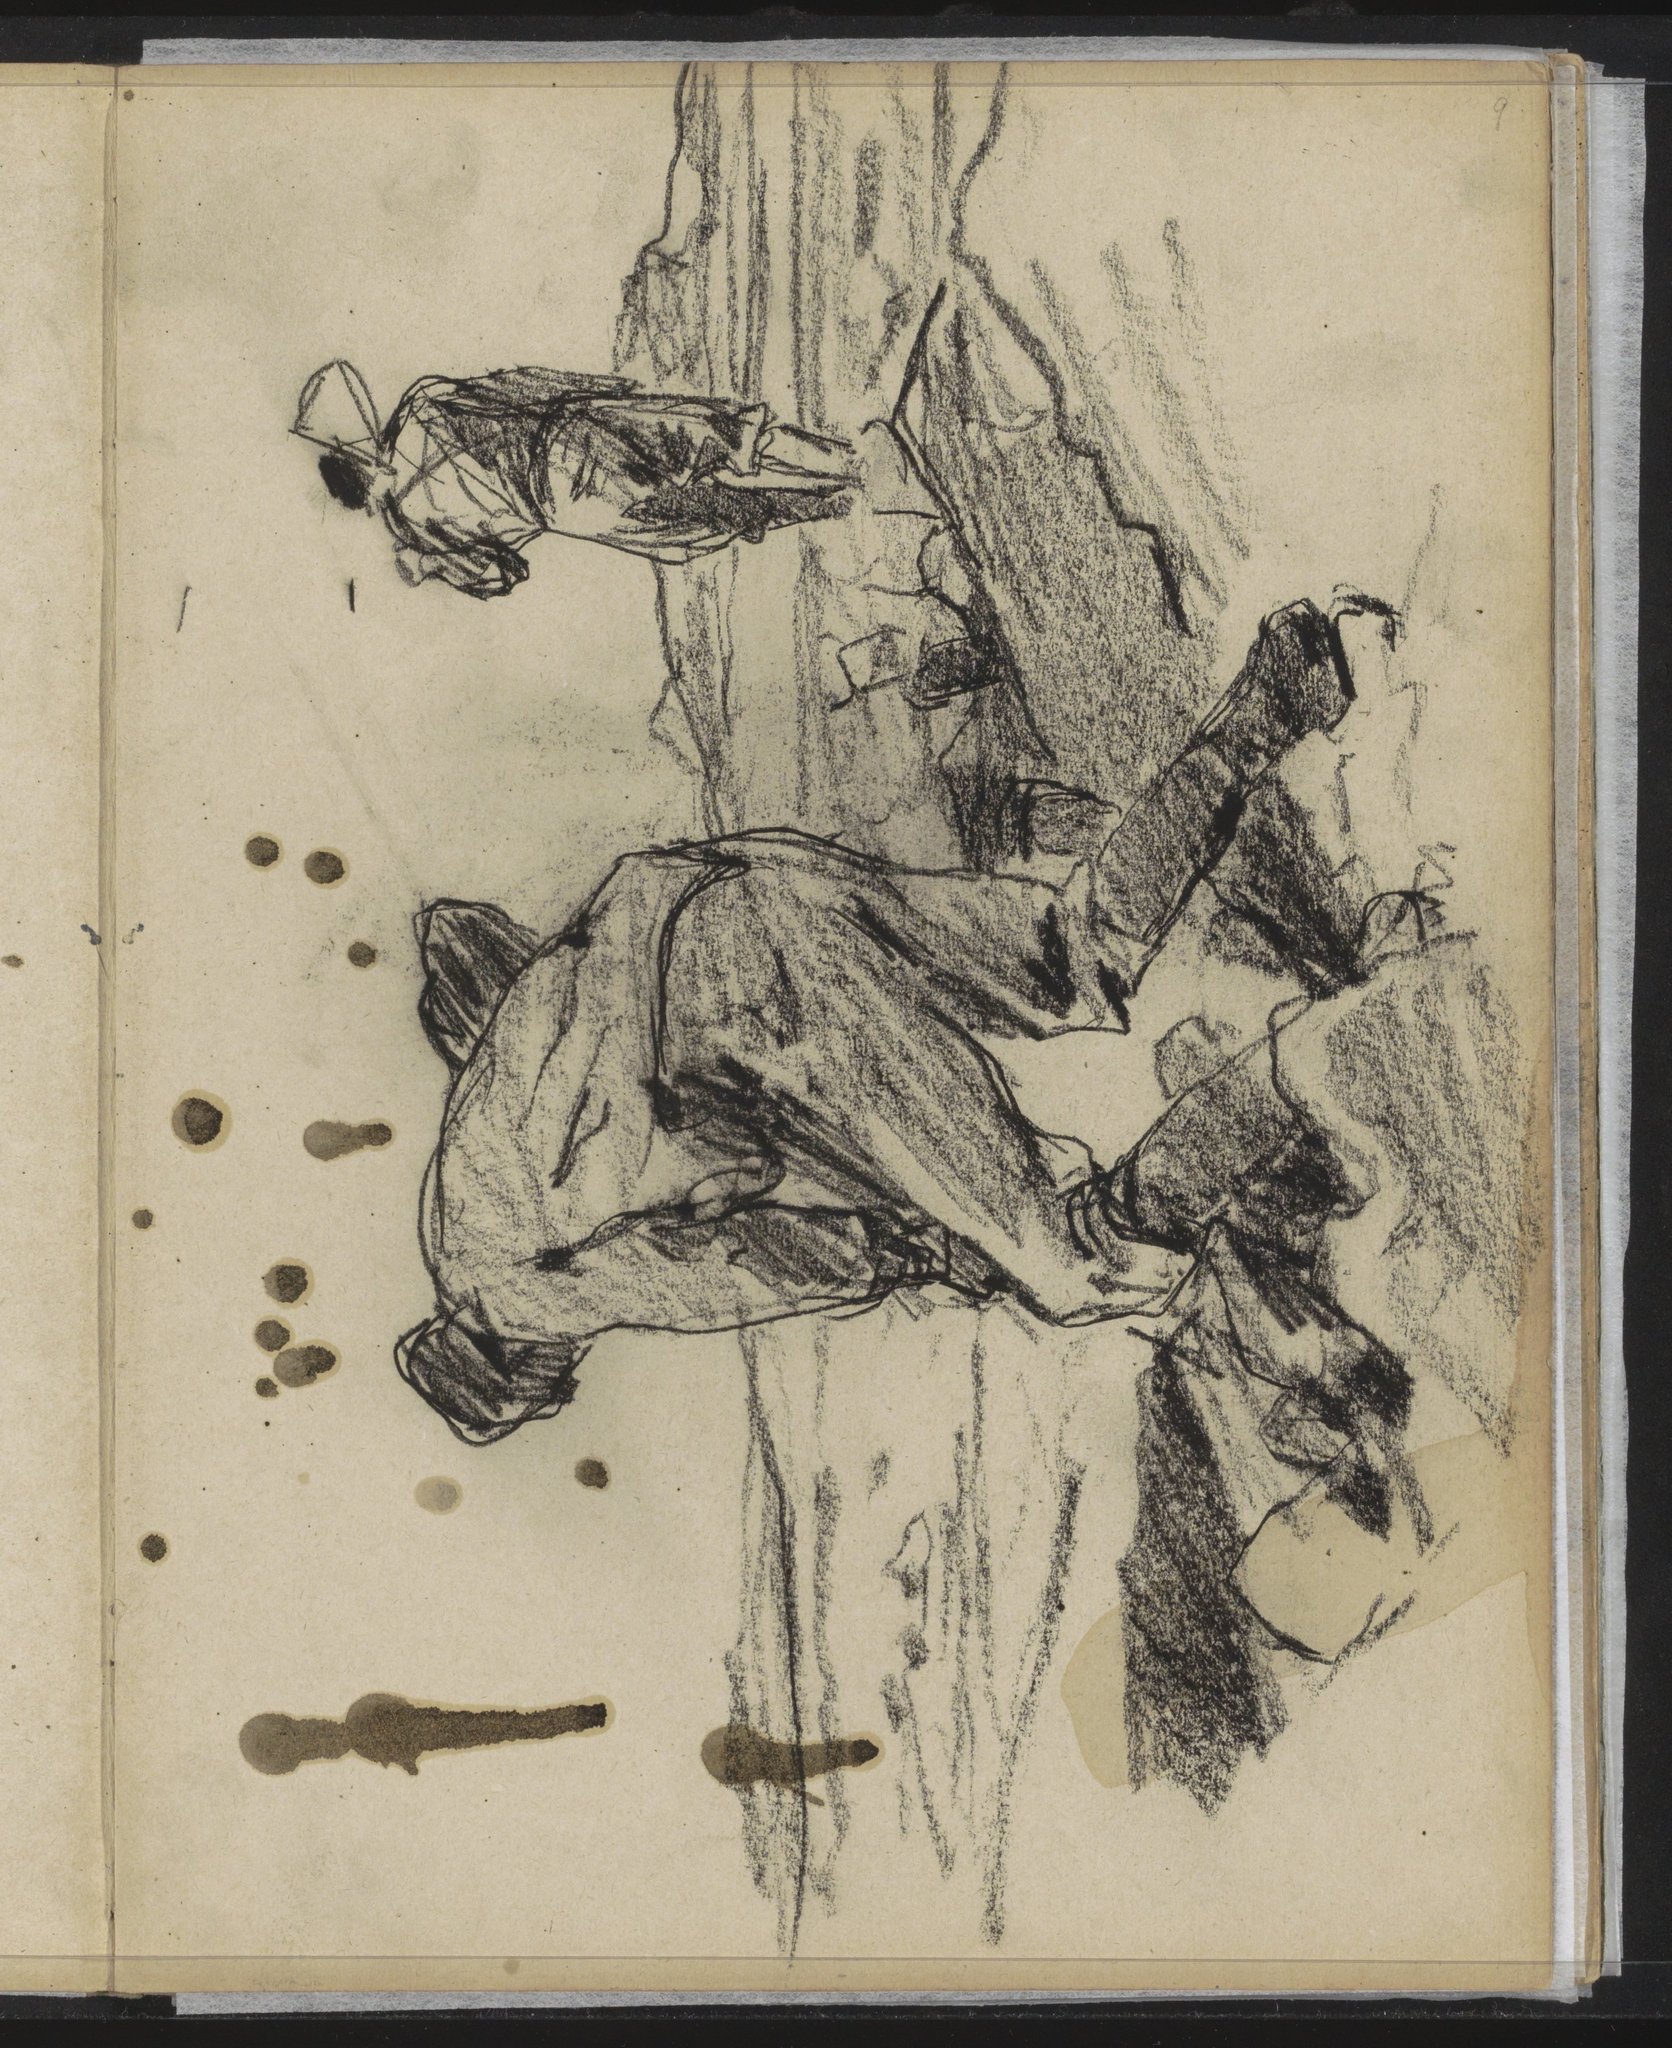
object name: sketchbook leaf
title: Heiwerkers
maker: willem witsen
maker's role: draughtsman, painter, print maker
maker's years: 1860-1923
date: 1884-1886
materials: chalk, paper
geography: ewijkshoeve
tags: building-site (+ men (labourers))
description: Rechts loopt een man met een spade over zijn schouder weg. Pagina 9 uit een schetsboek met 49 bladen.